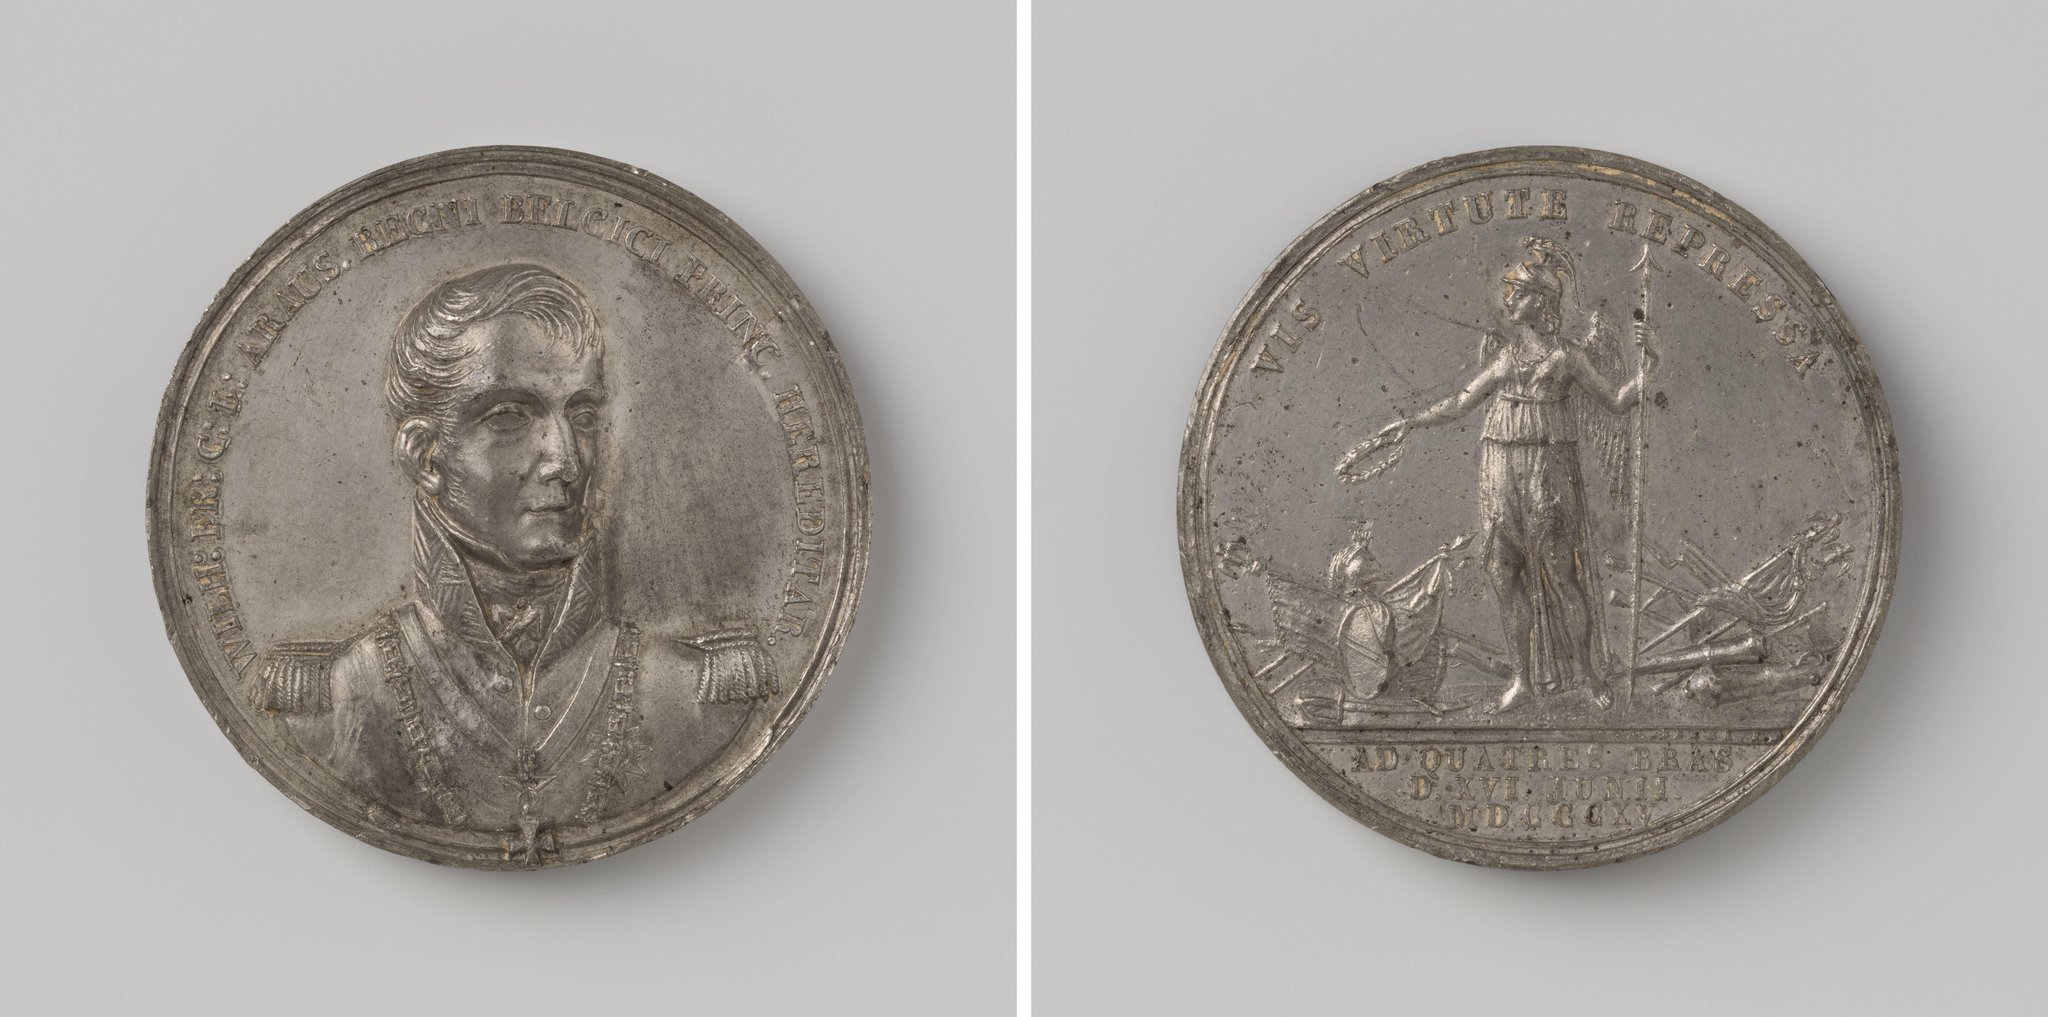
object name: history medal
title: Slag bij Quatre-Bras, ter ere van Willem Frederik George Lodewijk, erfprins der Nederlanden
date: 1815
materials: alloy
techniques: striking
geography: netherlands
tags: the hague, william ii of the netherlands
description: Slag bij Quatre-Bras (16 juni 1815), ter ere van Willem Frederik George Lodewijk, erfprins der Nederlanden. Penning. Voorzijde: borststuk man binnen omschrift. Keerzijde: gevleugelde Overwinning met helm, speer en lauwerkrans staande tussen veroverd wapentuig binnen omschrift; afsnede: opschrift.